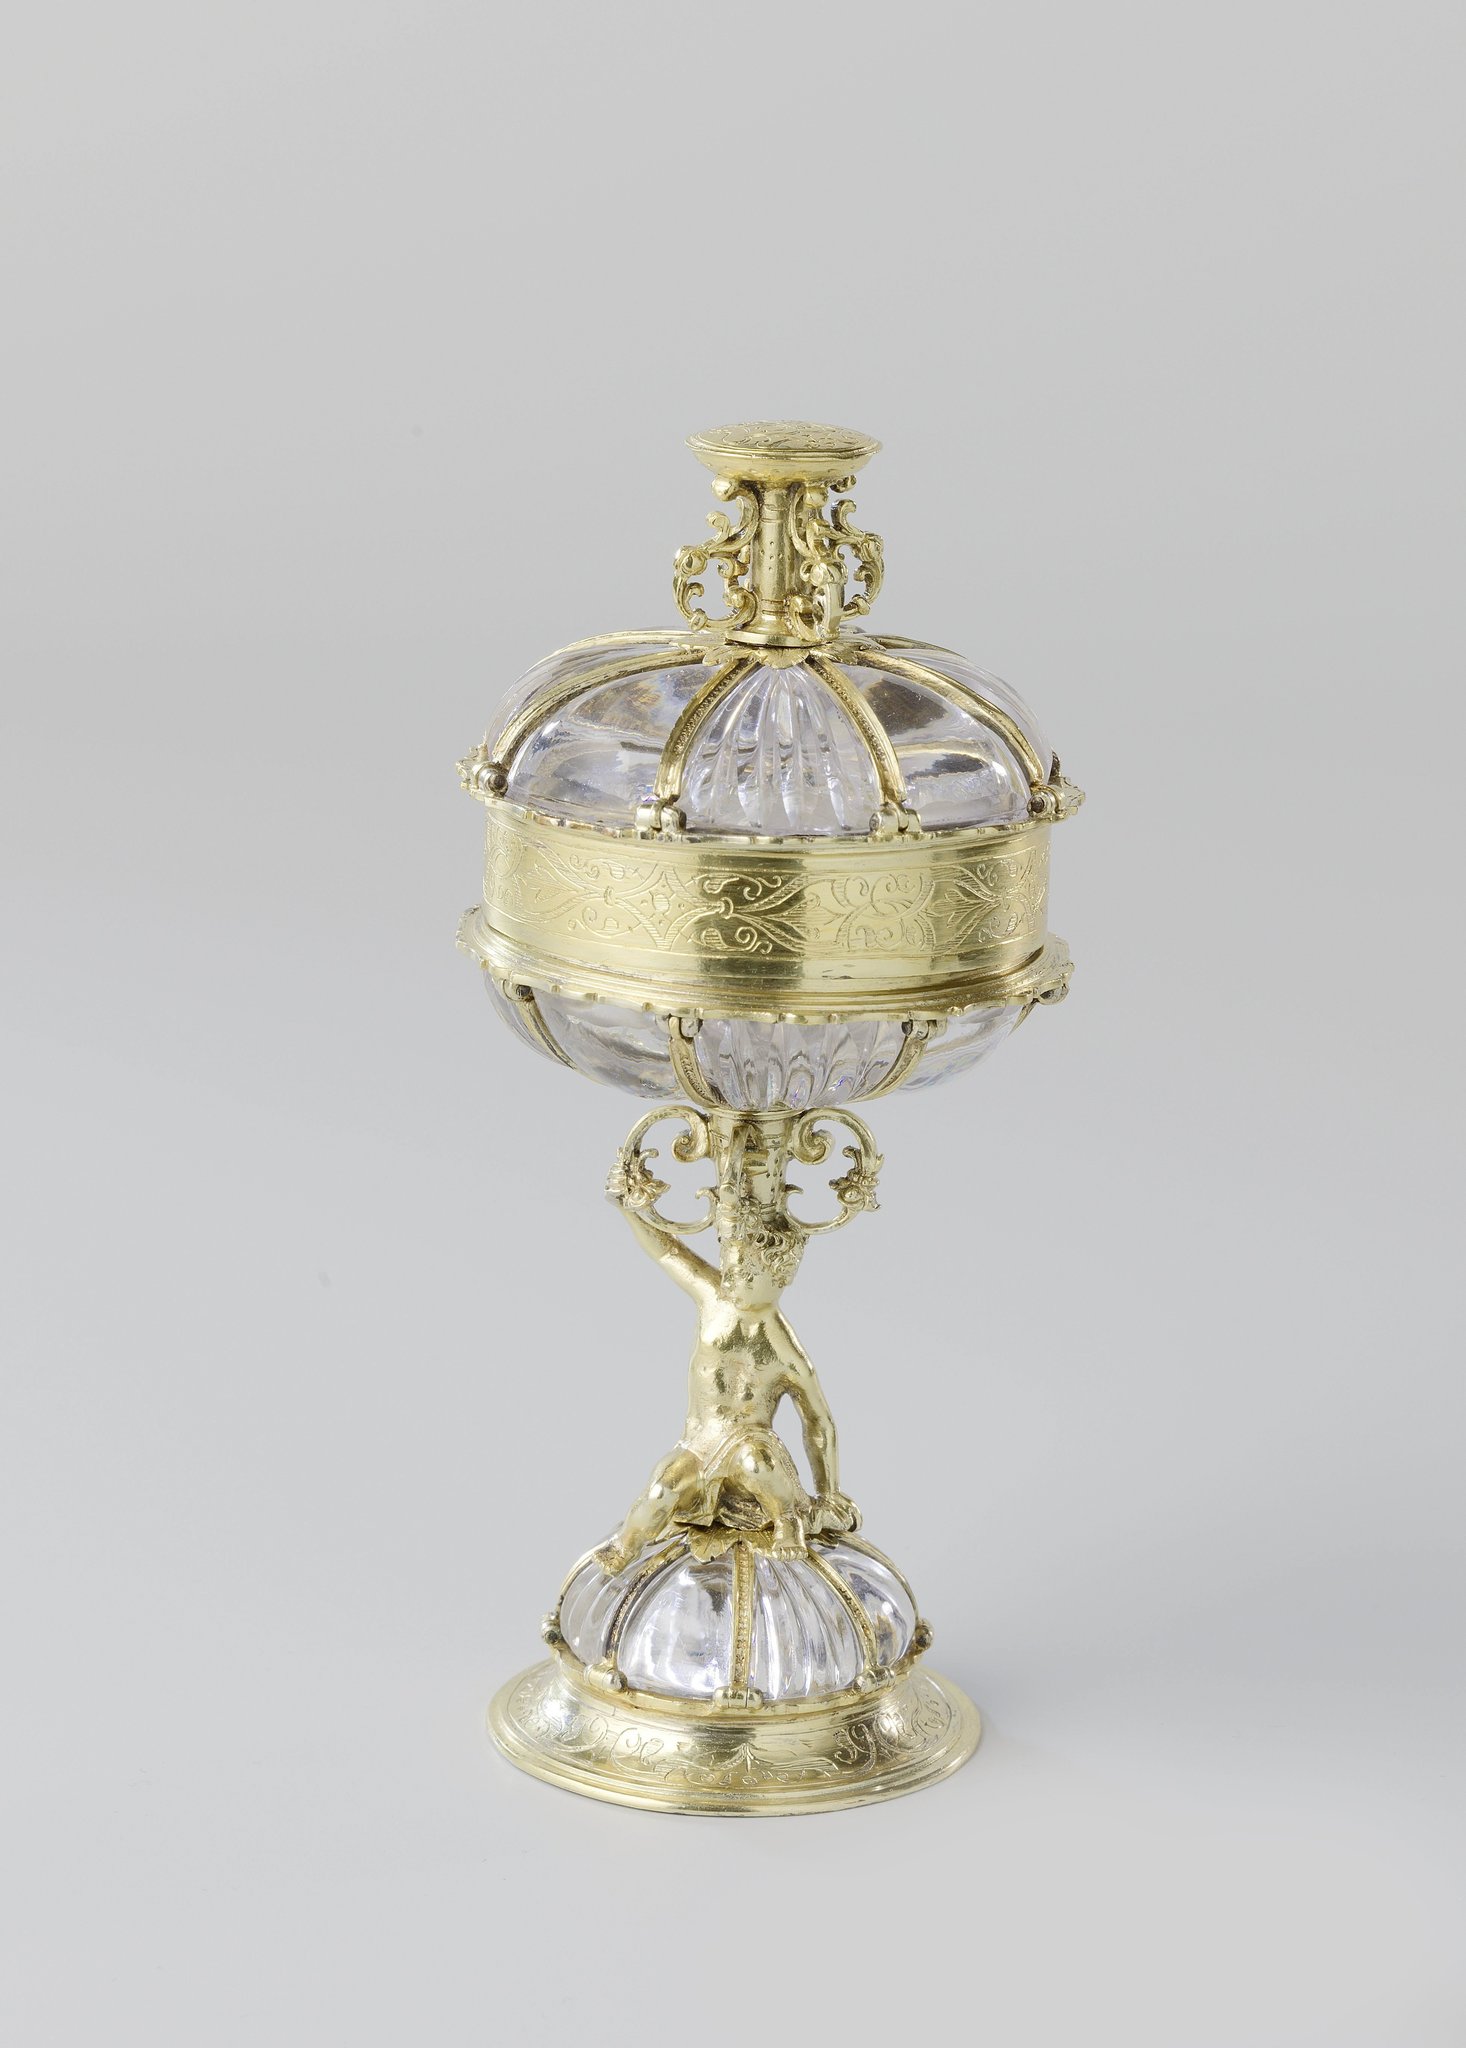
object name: goblet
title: Bokaal met deksel, van bergkristal met montuur van verguld zilver. Op koepelvormige voet een naakte jongeling die met één hand het montuur van het vat vasthoudt.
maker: Anonymous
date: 1590-1610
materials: silver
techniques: gilding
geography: southern germany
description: Covered cup. Rock crystal and silver-gilt. Southern Germany, c. 1600.